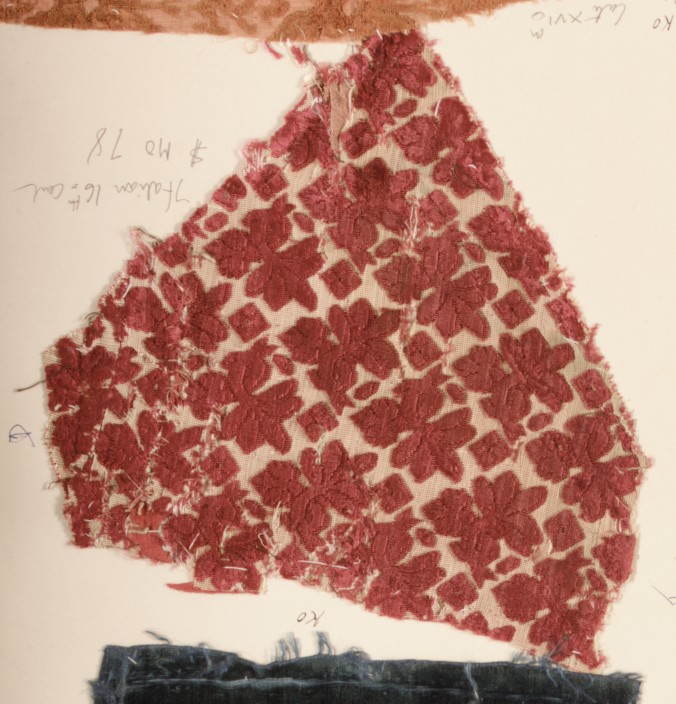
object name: fragment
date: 1501-1600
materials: silk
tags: leaves